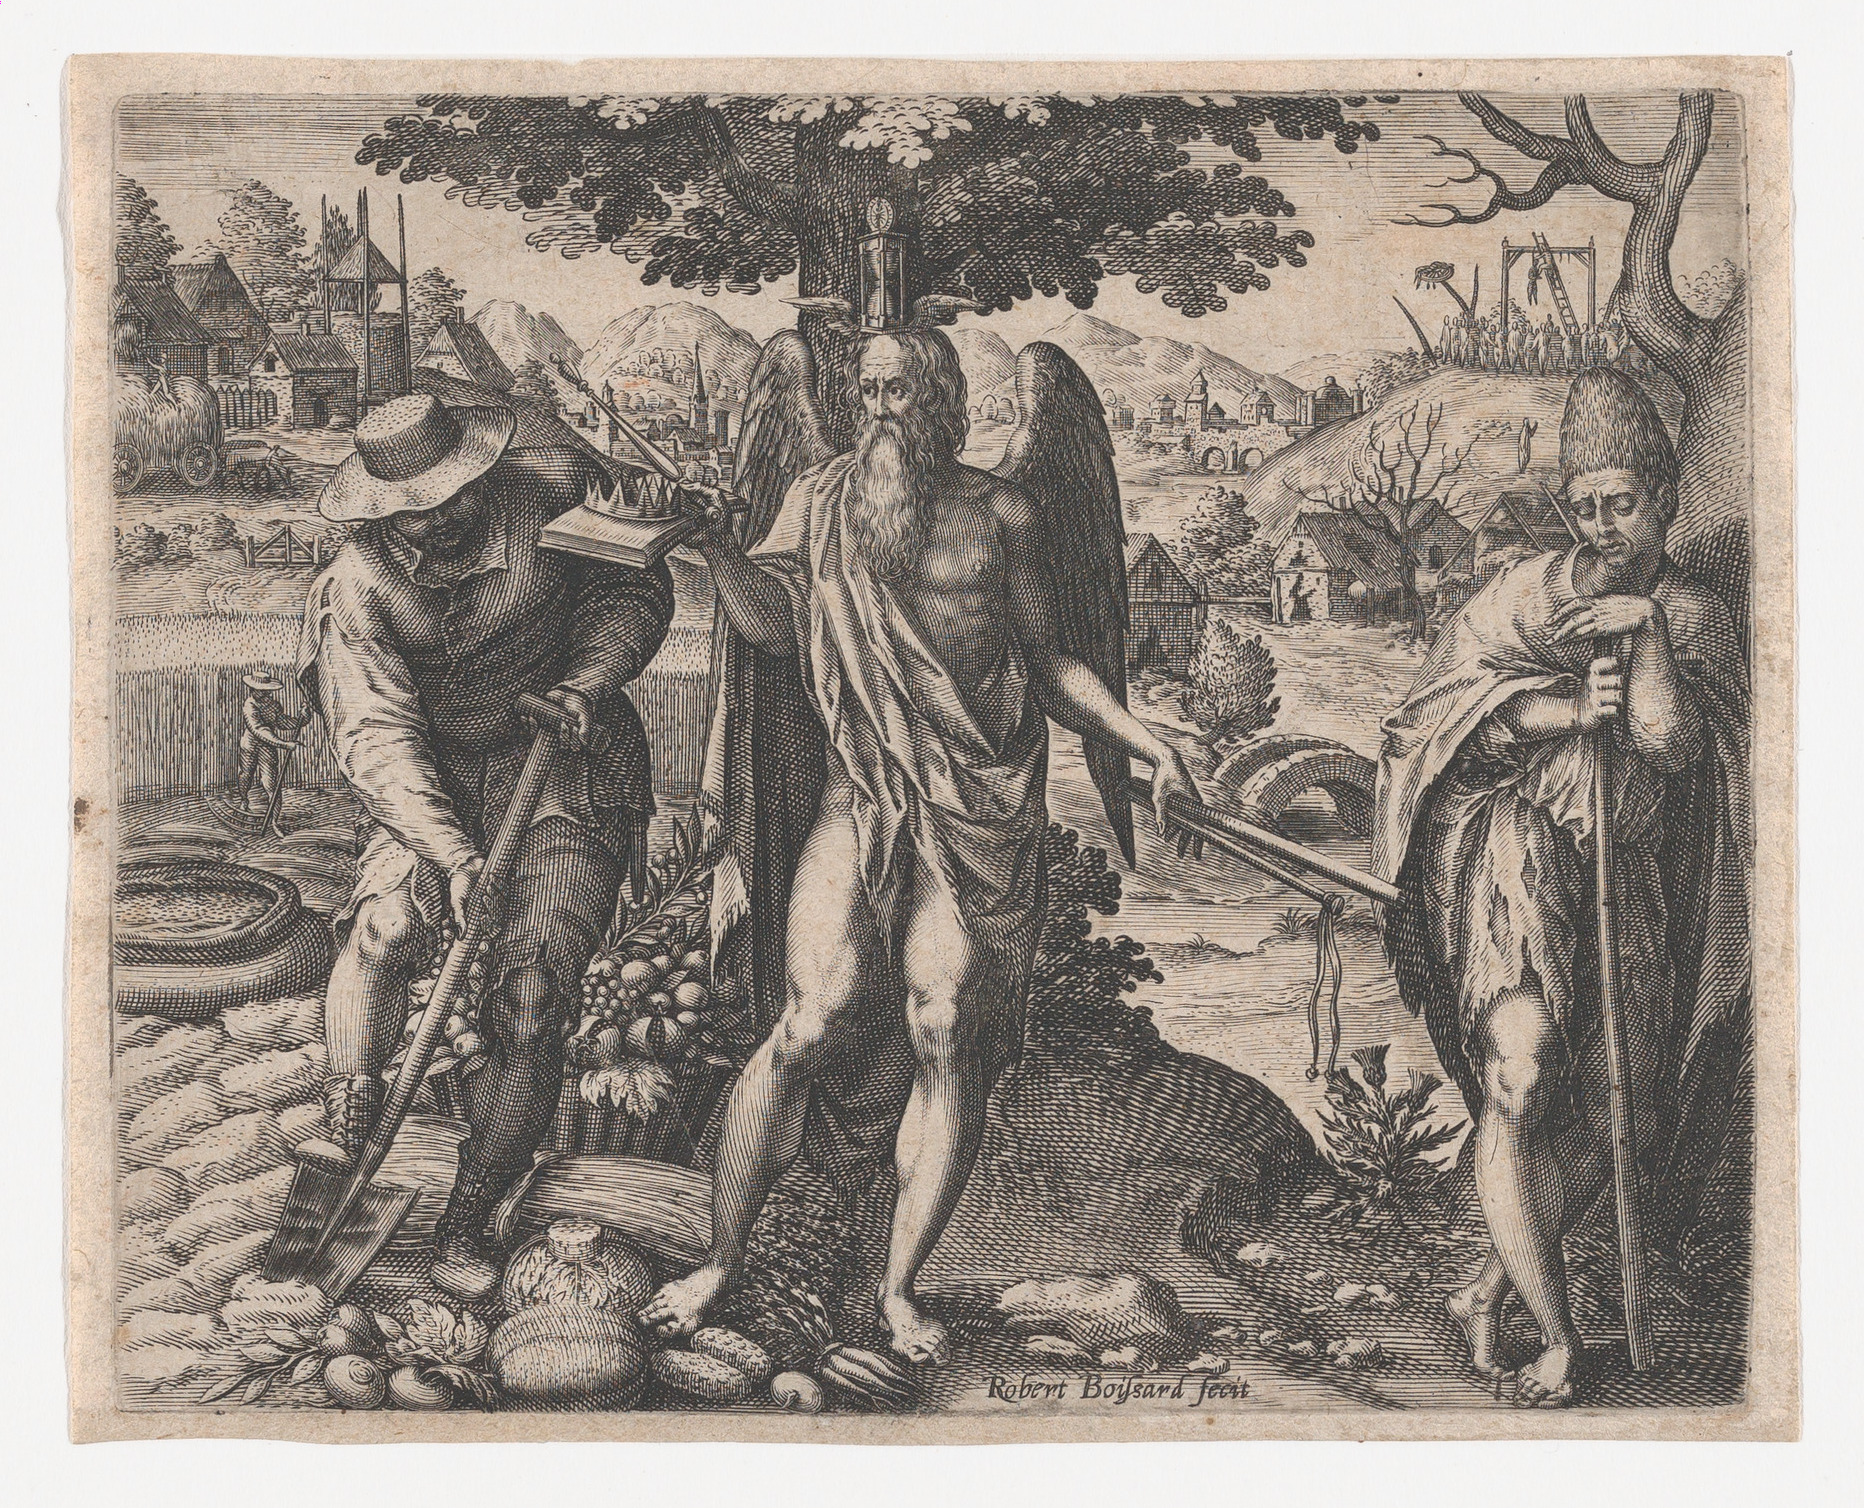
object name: print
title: Time Rewarding Work and Punishing Laziness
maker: robert boissard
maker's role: artist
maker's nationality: french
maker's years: 1586-1691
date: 1501-1600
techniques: engraving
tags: men,working